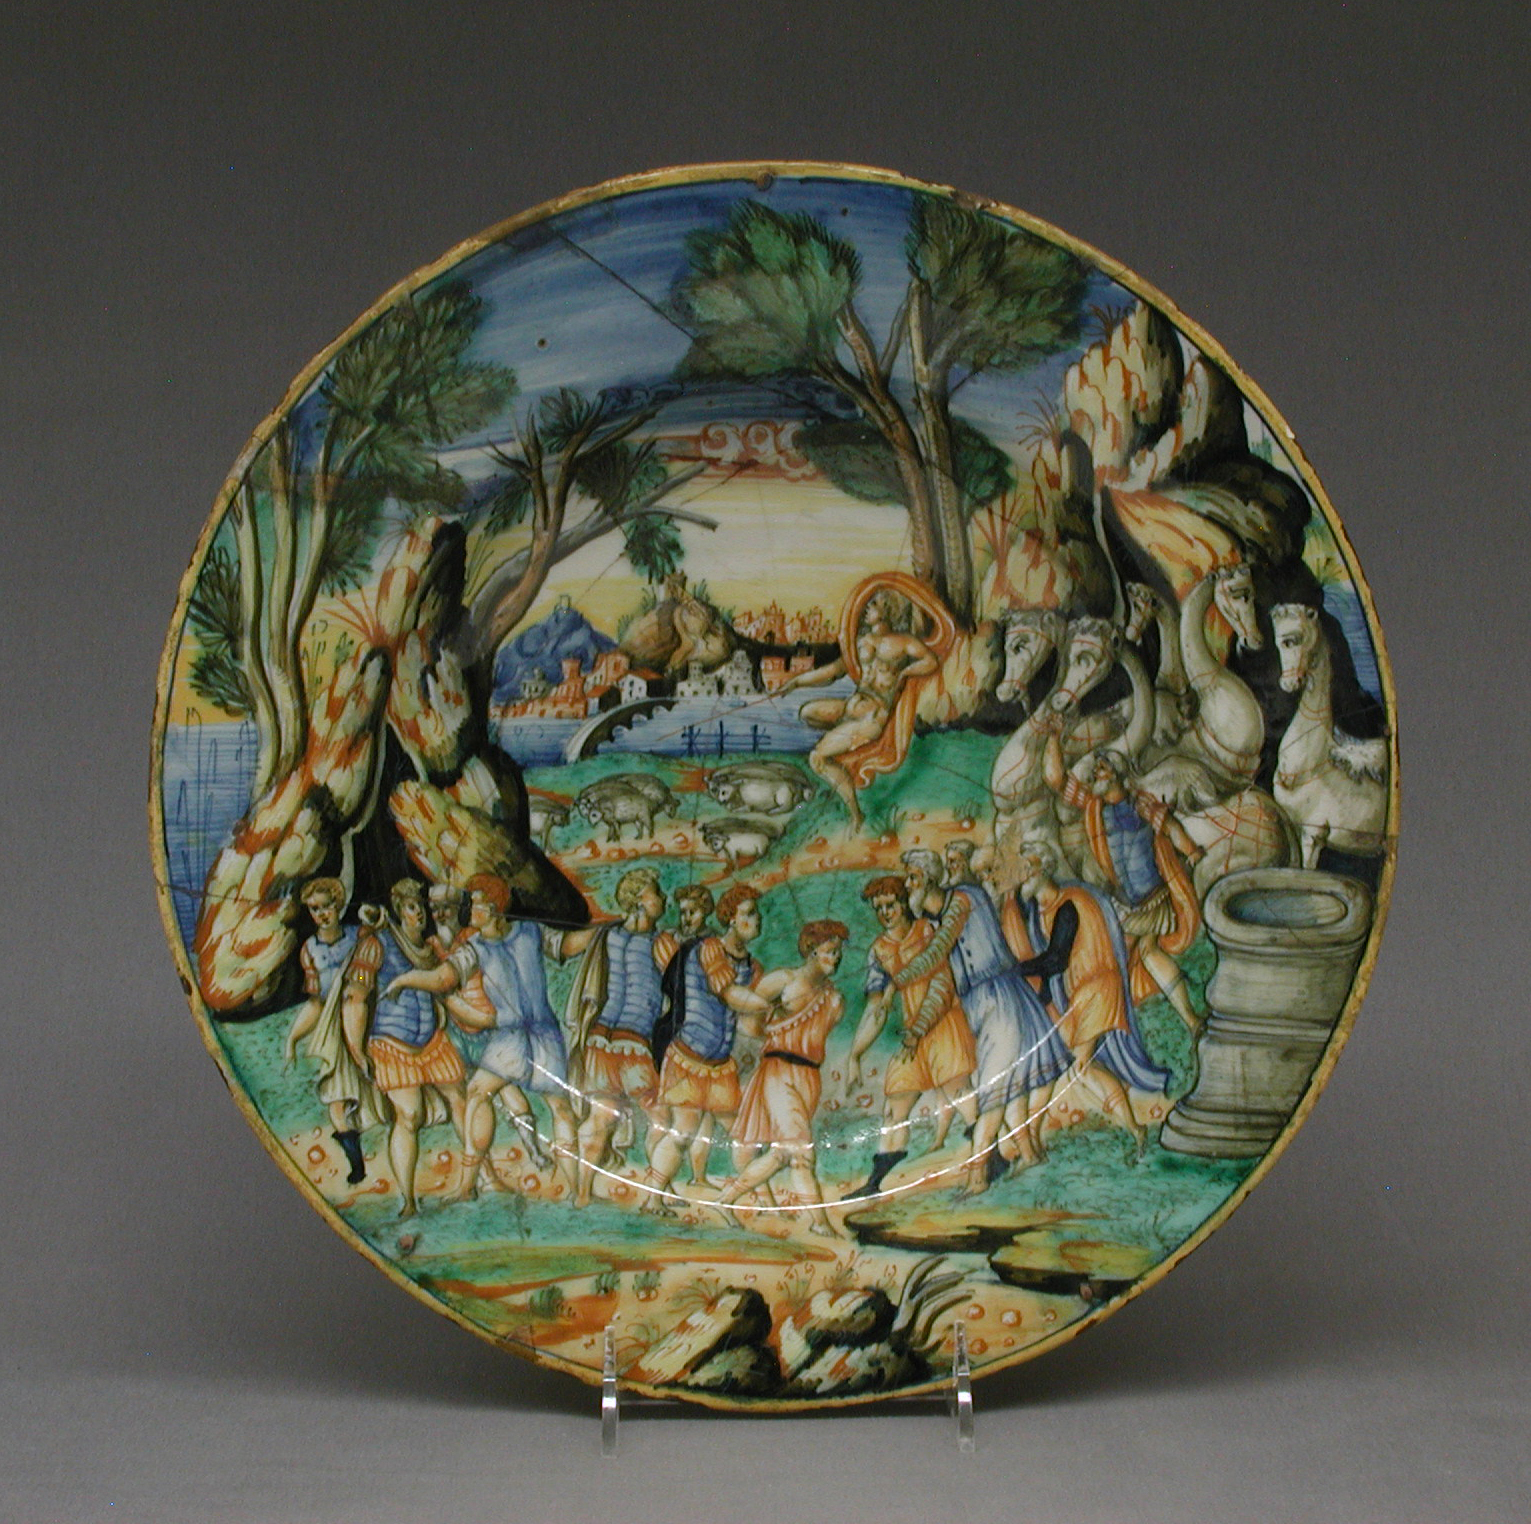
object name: plate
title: Plate with Joseph sold by his brothers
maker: andrea da negroponte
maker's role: maker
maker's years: 1500-1600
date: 1550-1555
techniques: maiolica, glazing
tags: men,camels